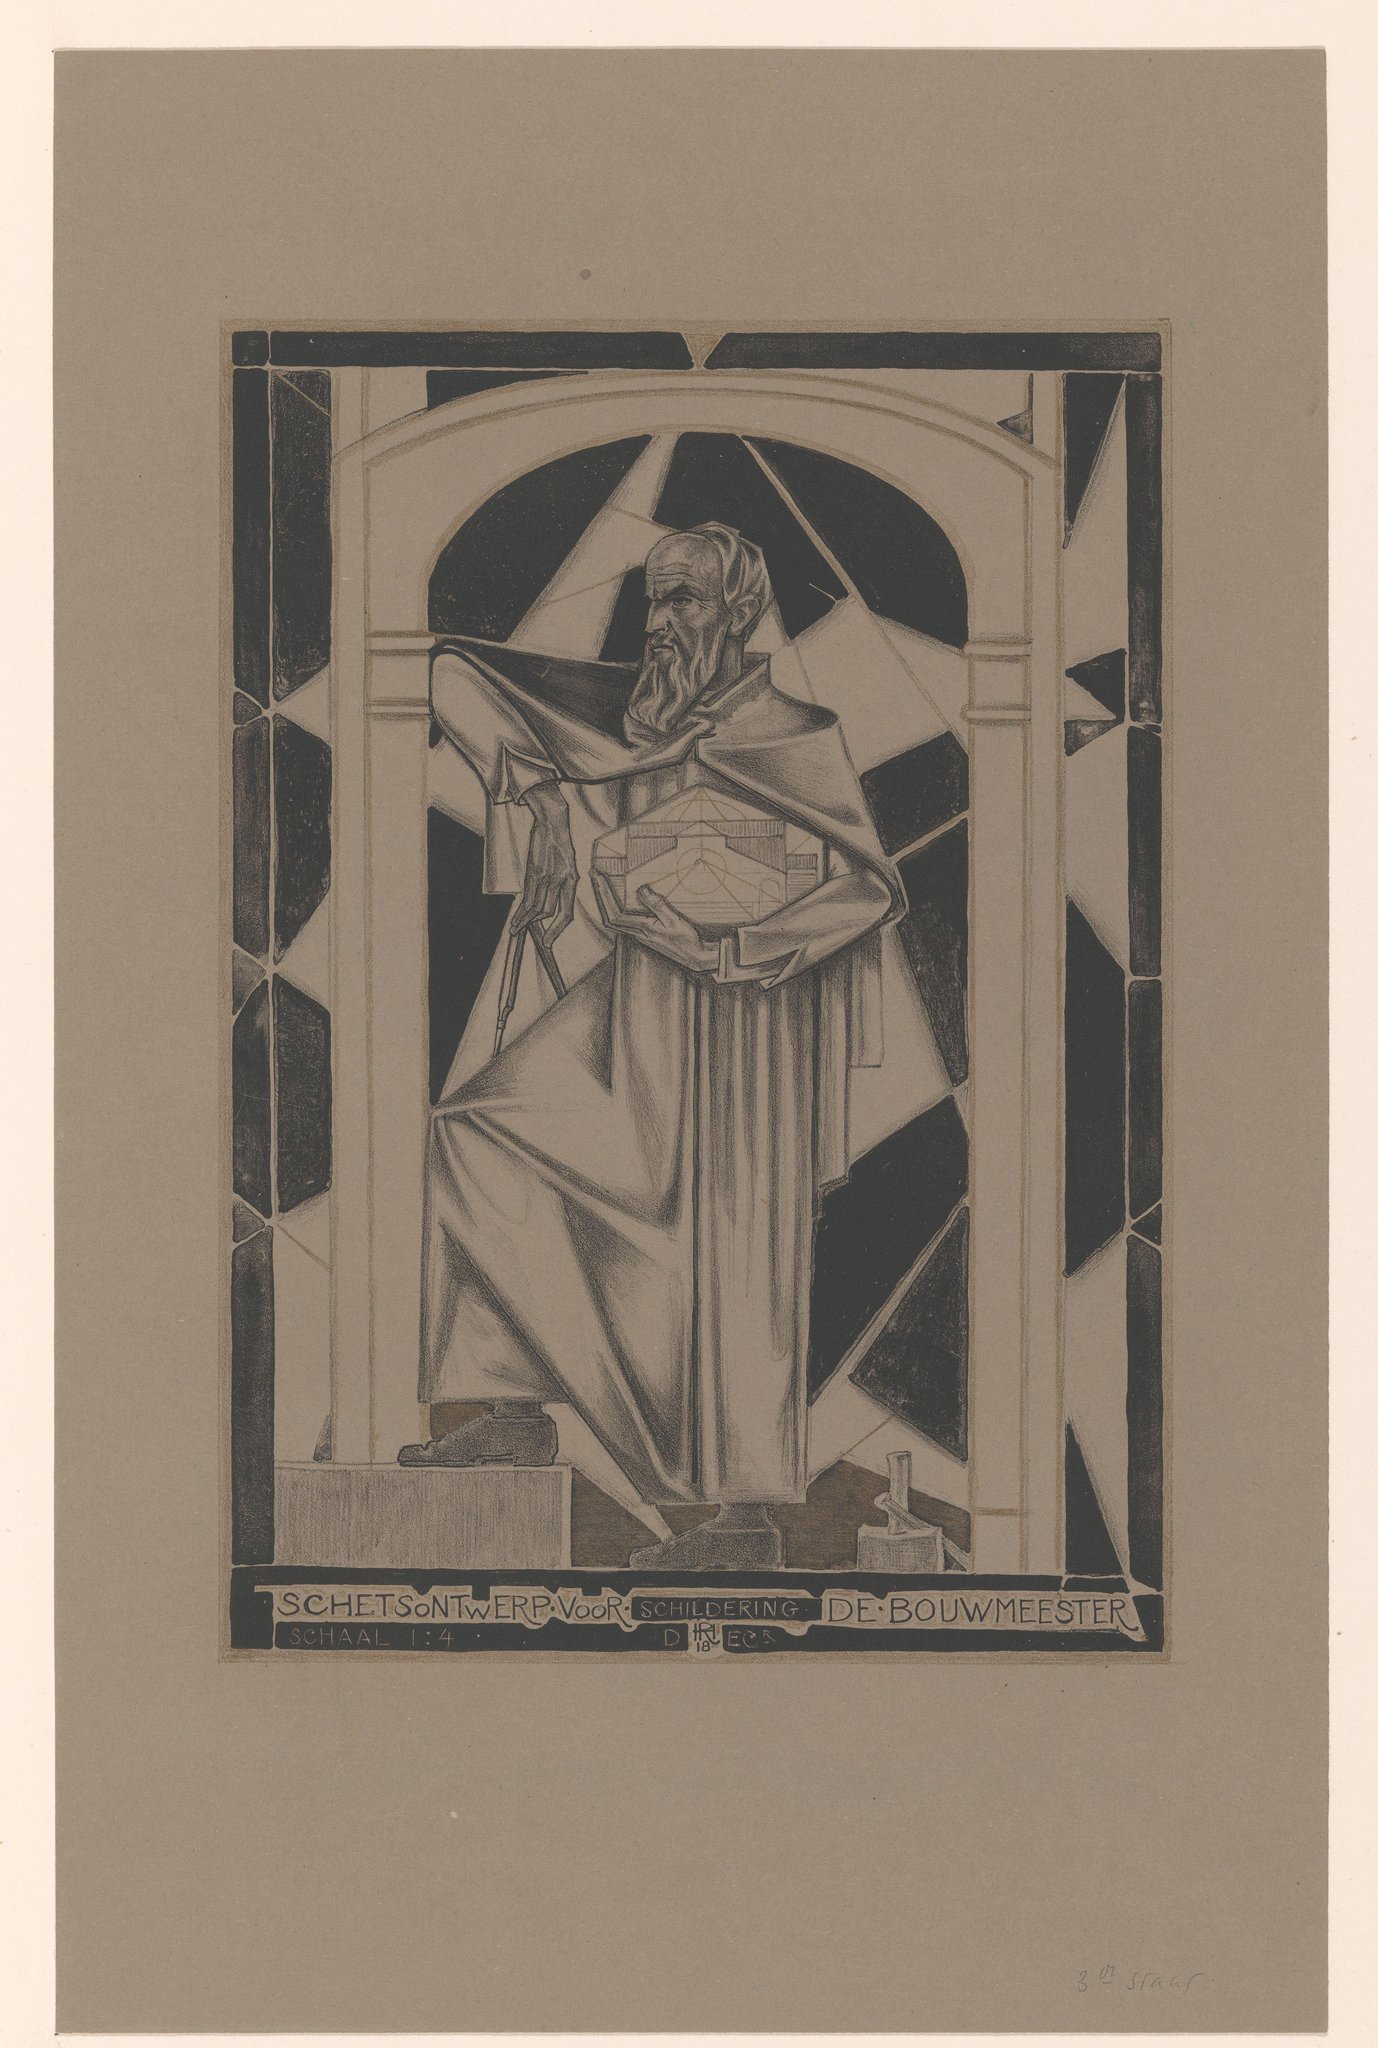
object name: print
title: De bouwmeester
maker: richard nicolaüs roland holst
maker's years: 1868-1938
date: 1918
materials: paper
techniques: lithograph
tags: architect in non-work situation, measuring-instruments, architectural design or model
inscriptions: collector's mark: Lugt 2228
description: Een bebaarde man, mogelijk Hiram, de architect van de Tempel van Salomo in Jeruzalem, houdt een passer en een model van een tempel vast.